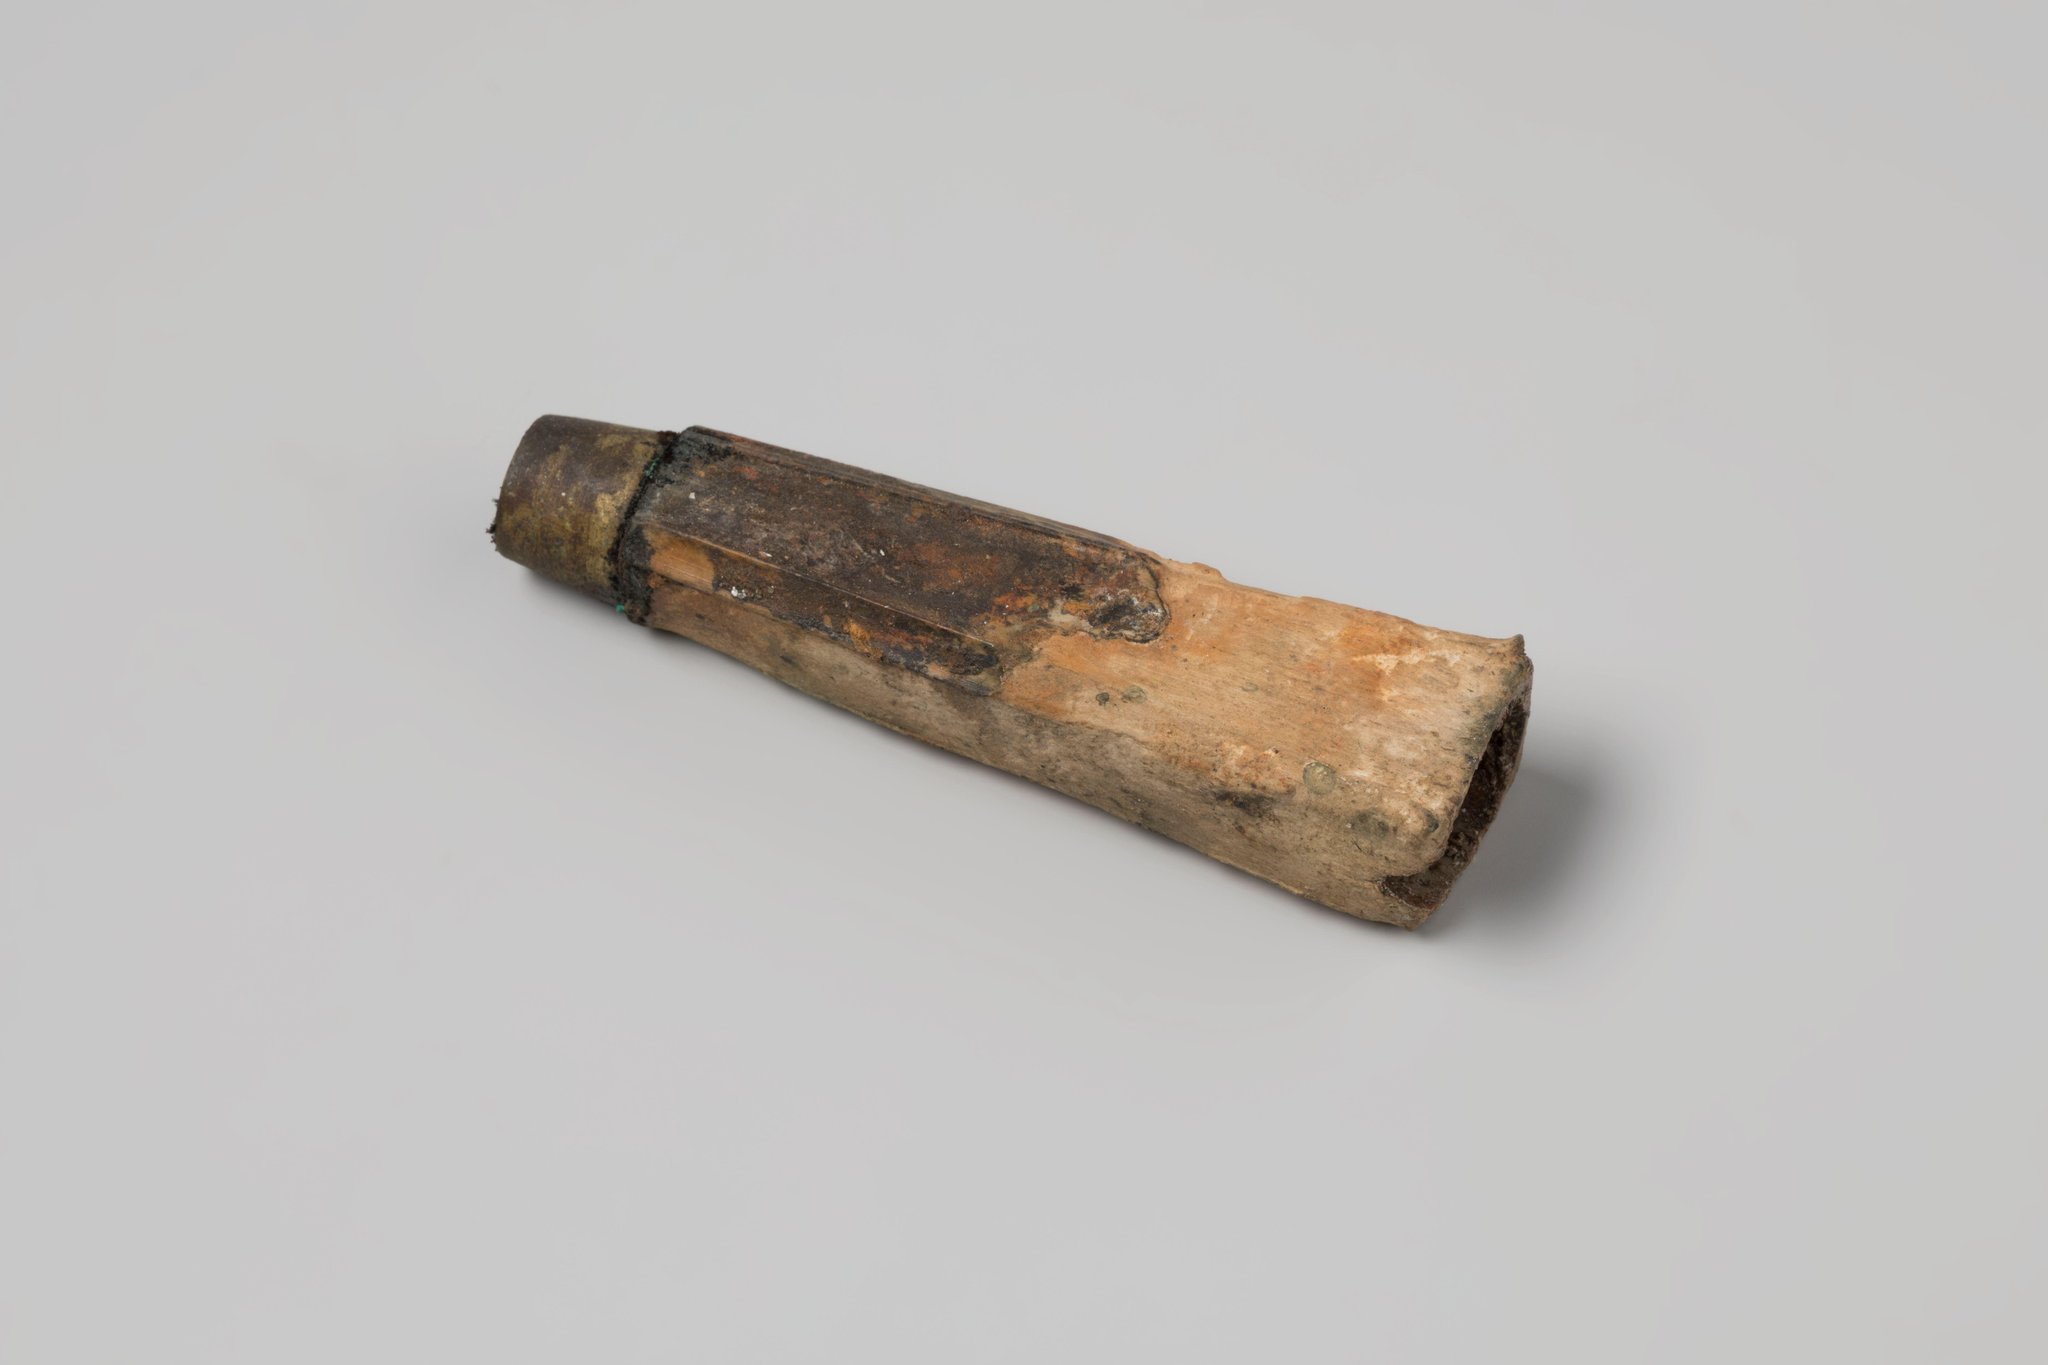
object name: knife handle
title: Messenheft uit het wrak van de Oost-Indiëvaarder Hollandia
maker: Anonymous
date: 1700-1743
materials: bone, brass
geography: netherlands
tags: verenigde oostindische compagnie, hollandia (schip), annet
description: Knife-handle, straight-sided: tapering; eroded, rectangular in section, tapering, flat upper end, edges ribbed, ferrule.